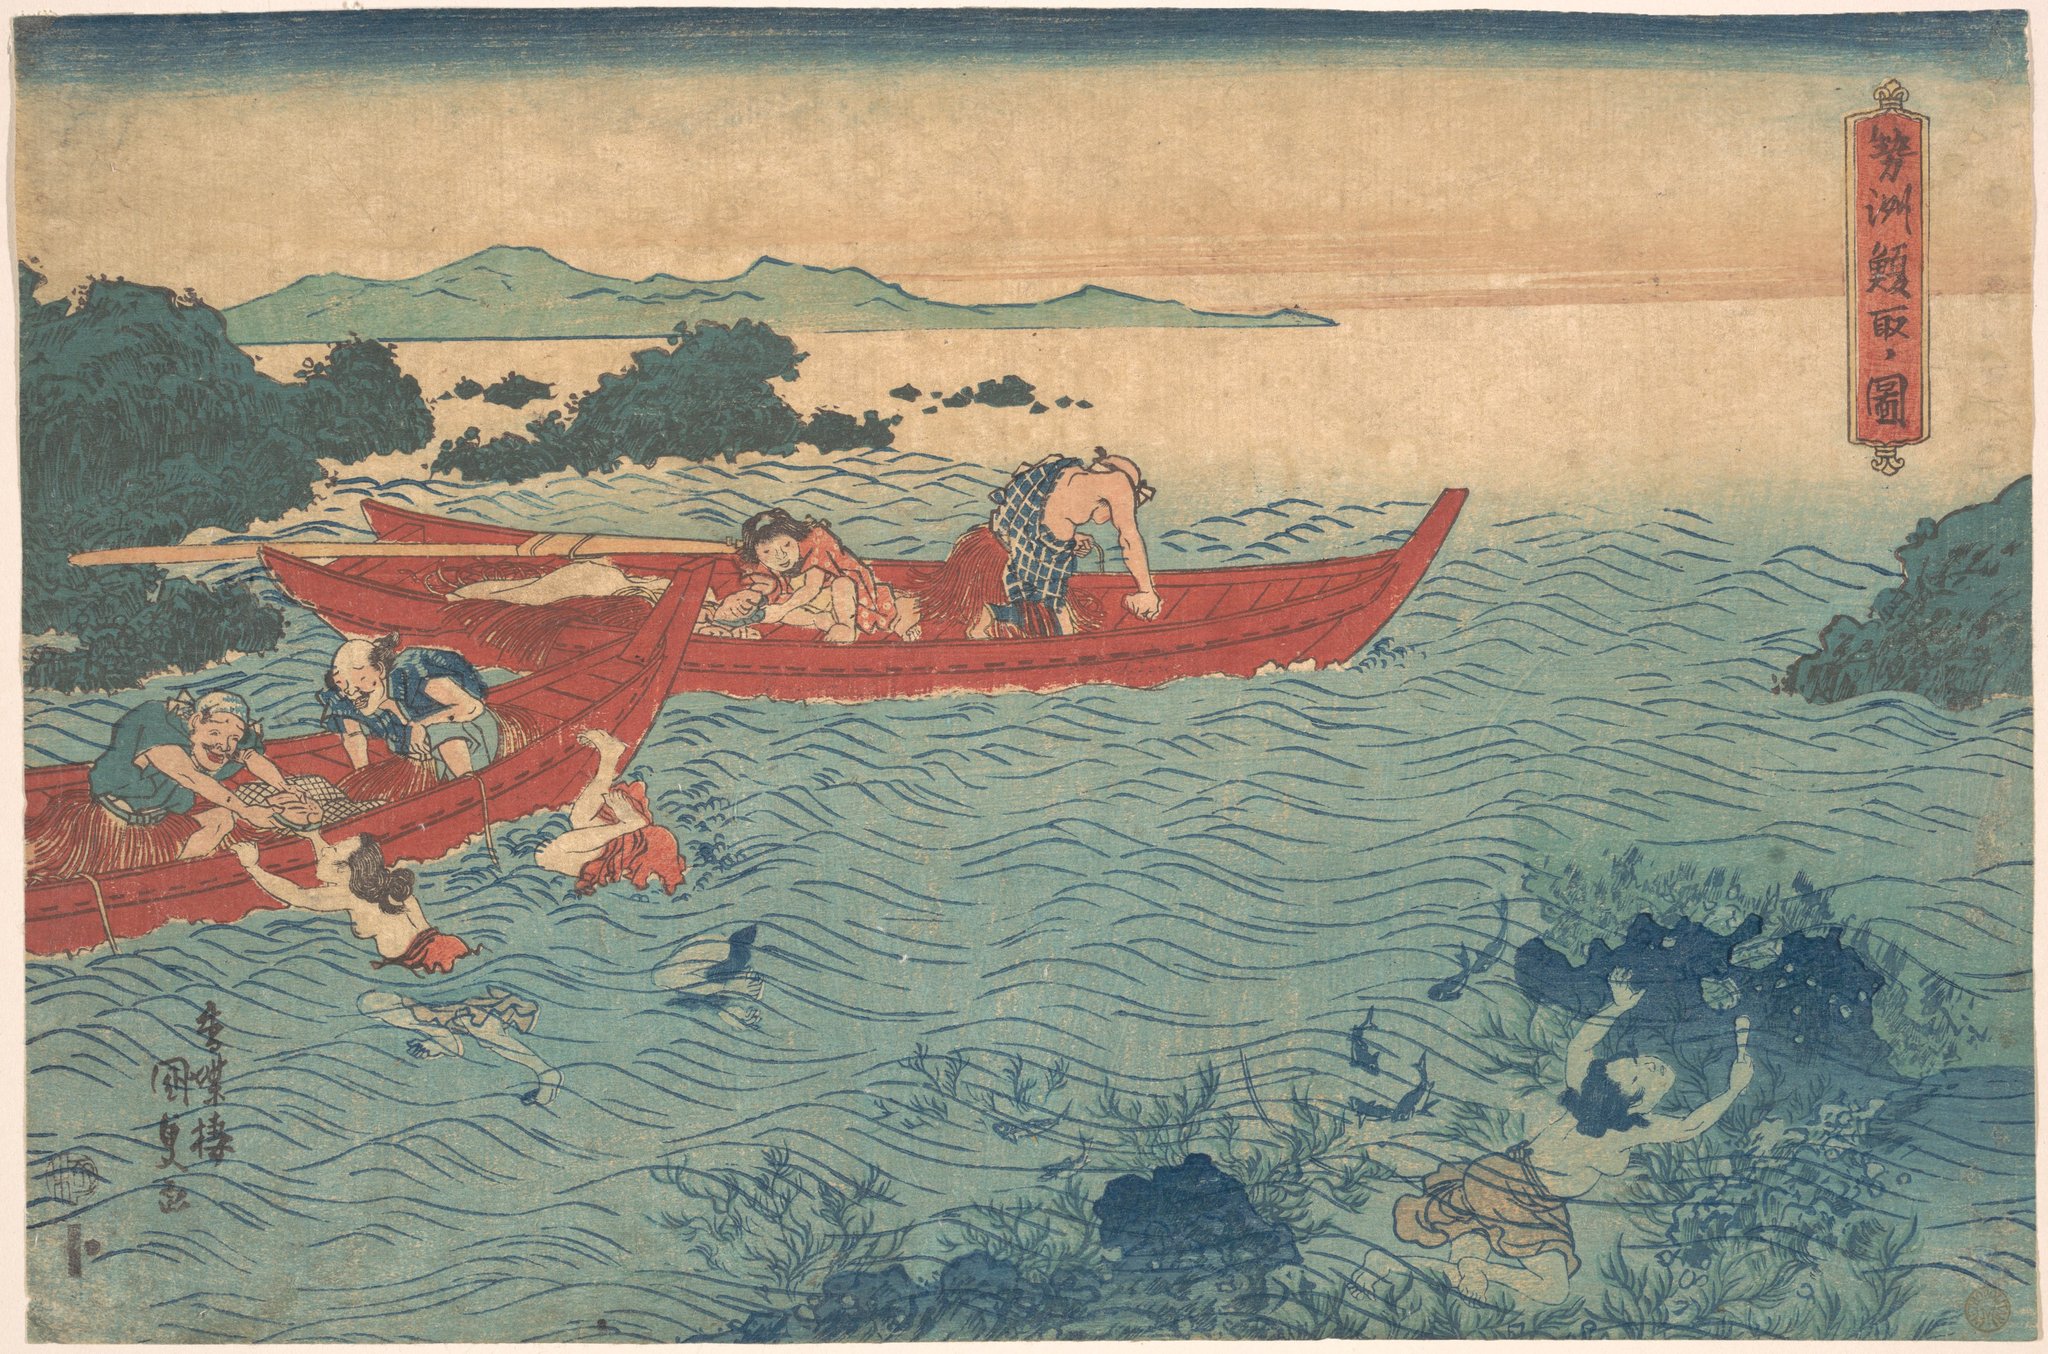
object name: print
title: Seishu Awabi-tori no Zu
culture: japanese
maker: utagawa kunisada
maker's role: artist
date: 1840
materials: ink, paper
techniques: woodblock print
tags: human figures,fish,boats